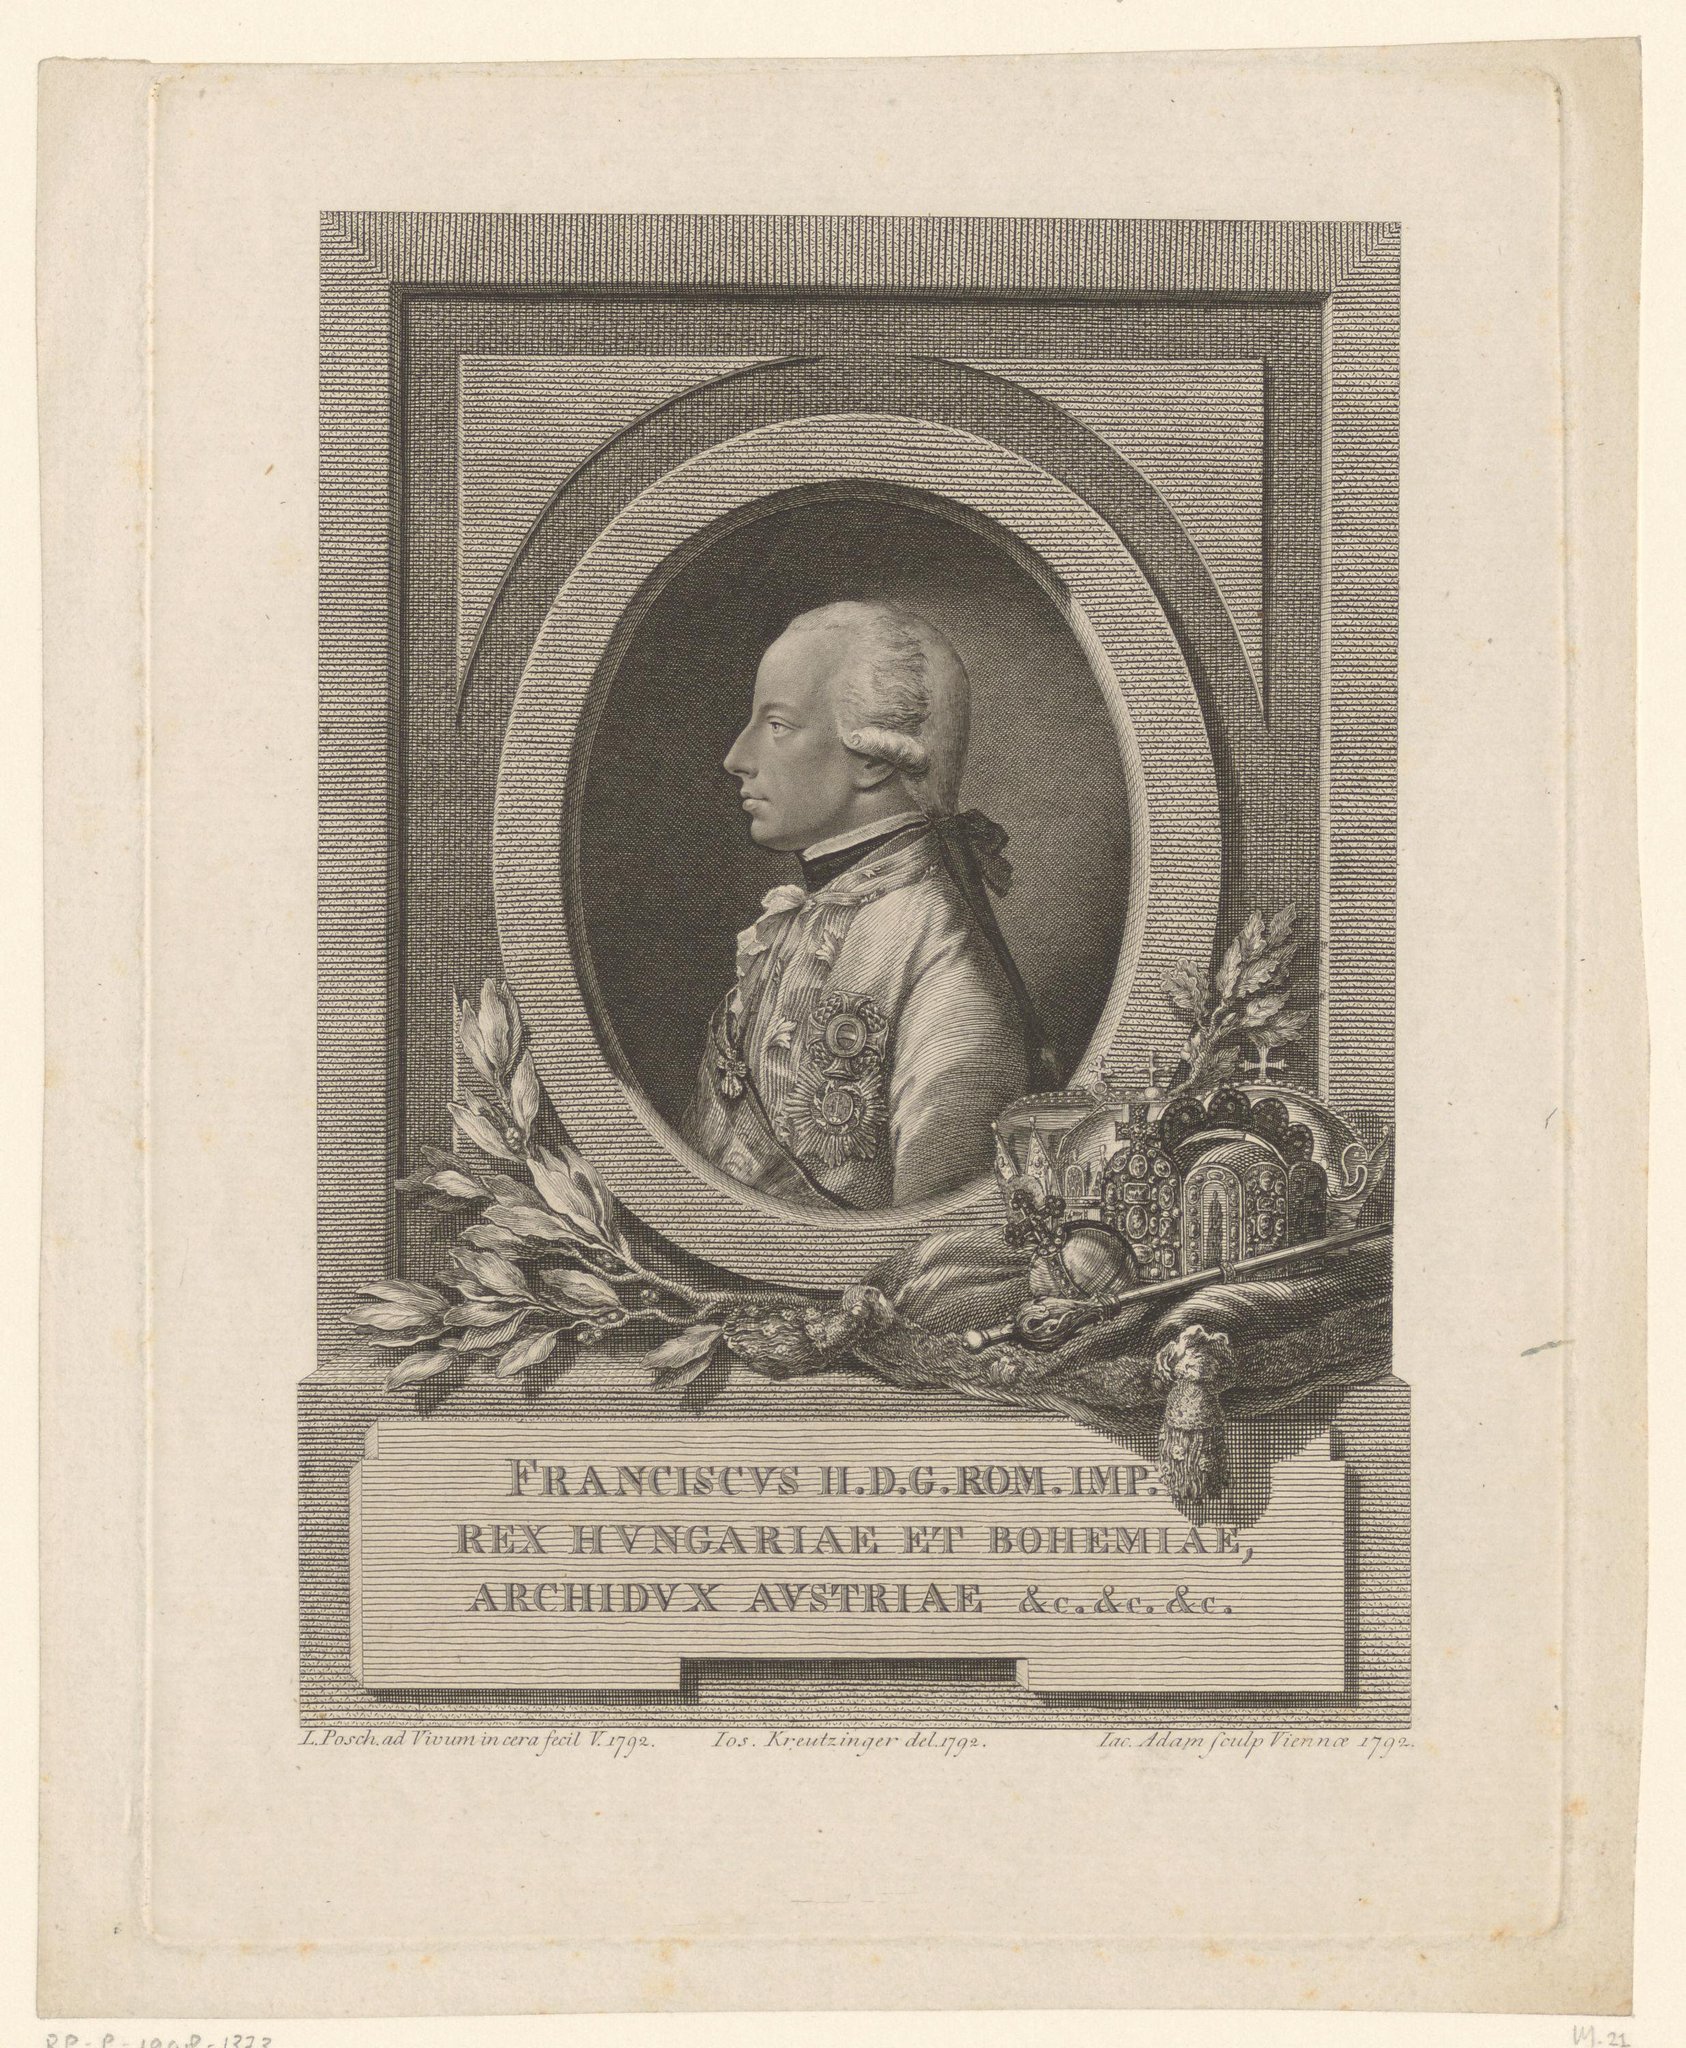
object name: print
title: Portret van Frans II van Oostenrijk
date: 1792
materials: paper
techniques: etching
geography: vienna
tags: vienna, frans ii (rooms-duits keizer), historical persons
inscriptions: collector's mark: Lugt 2228